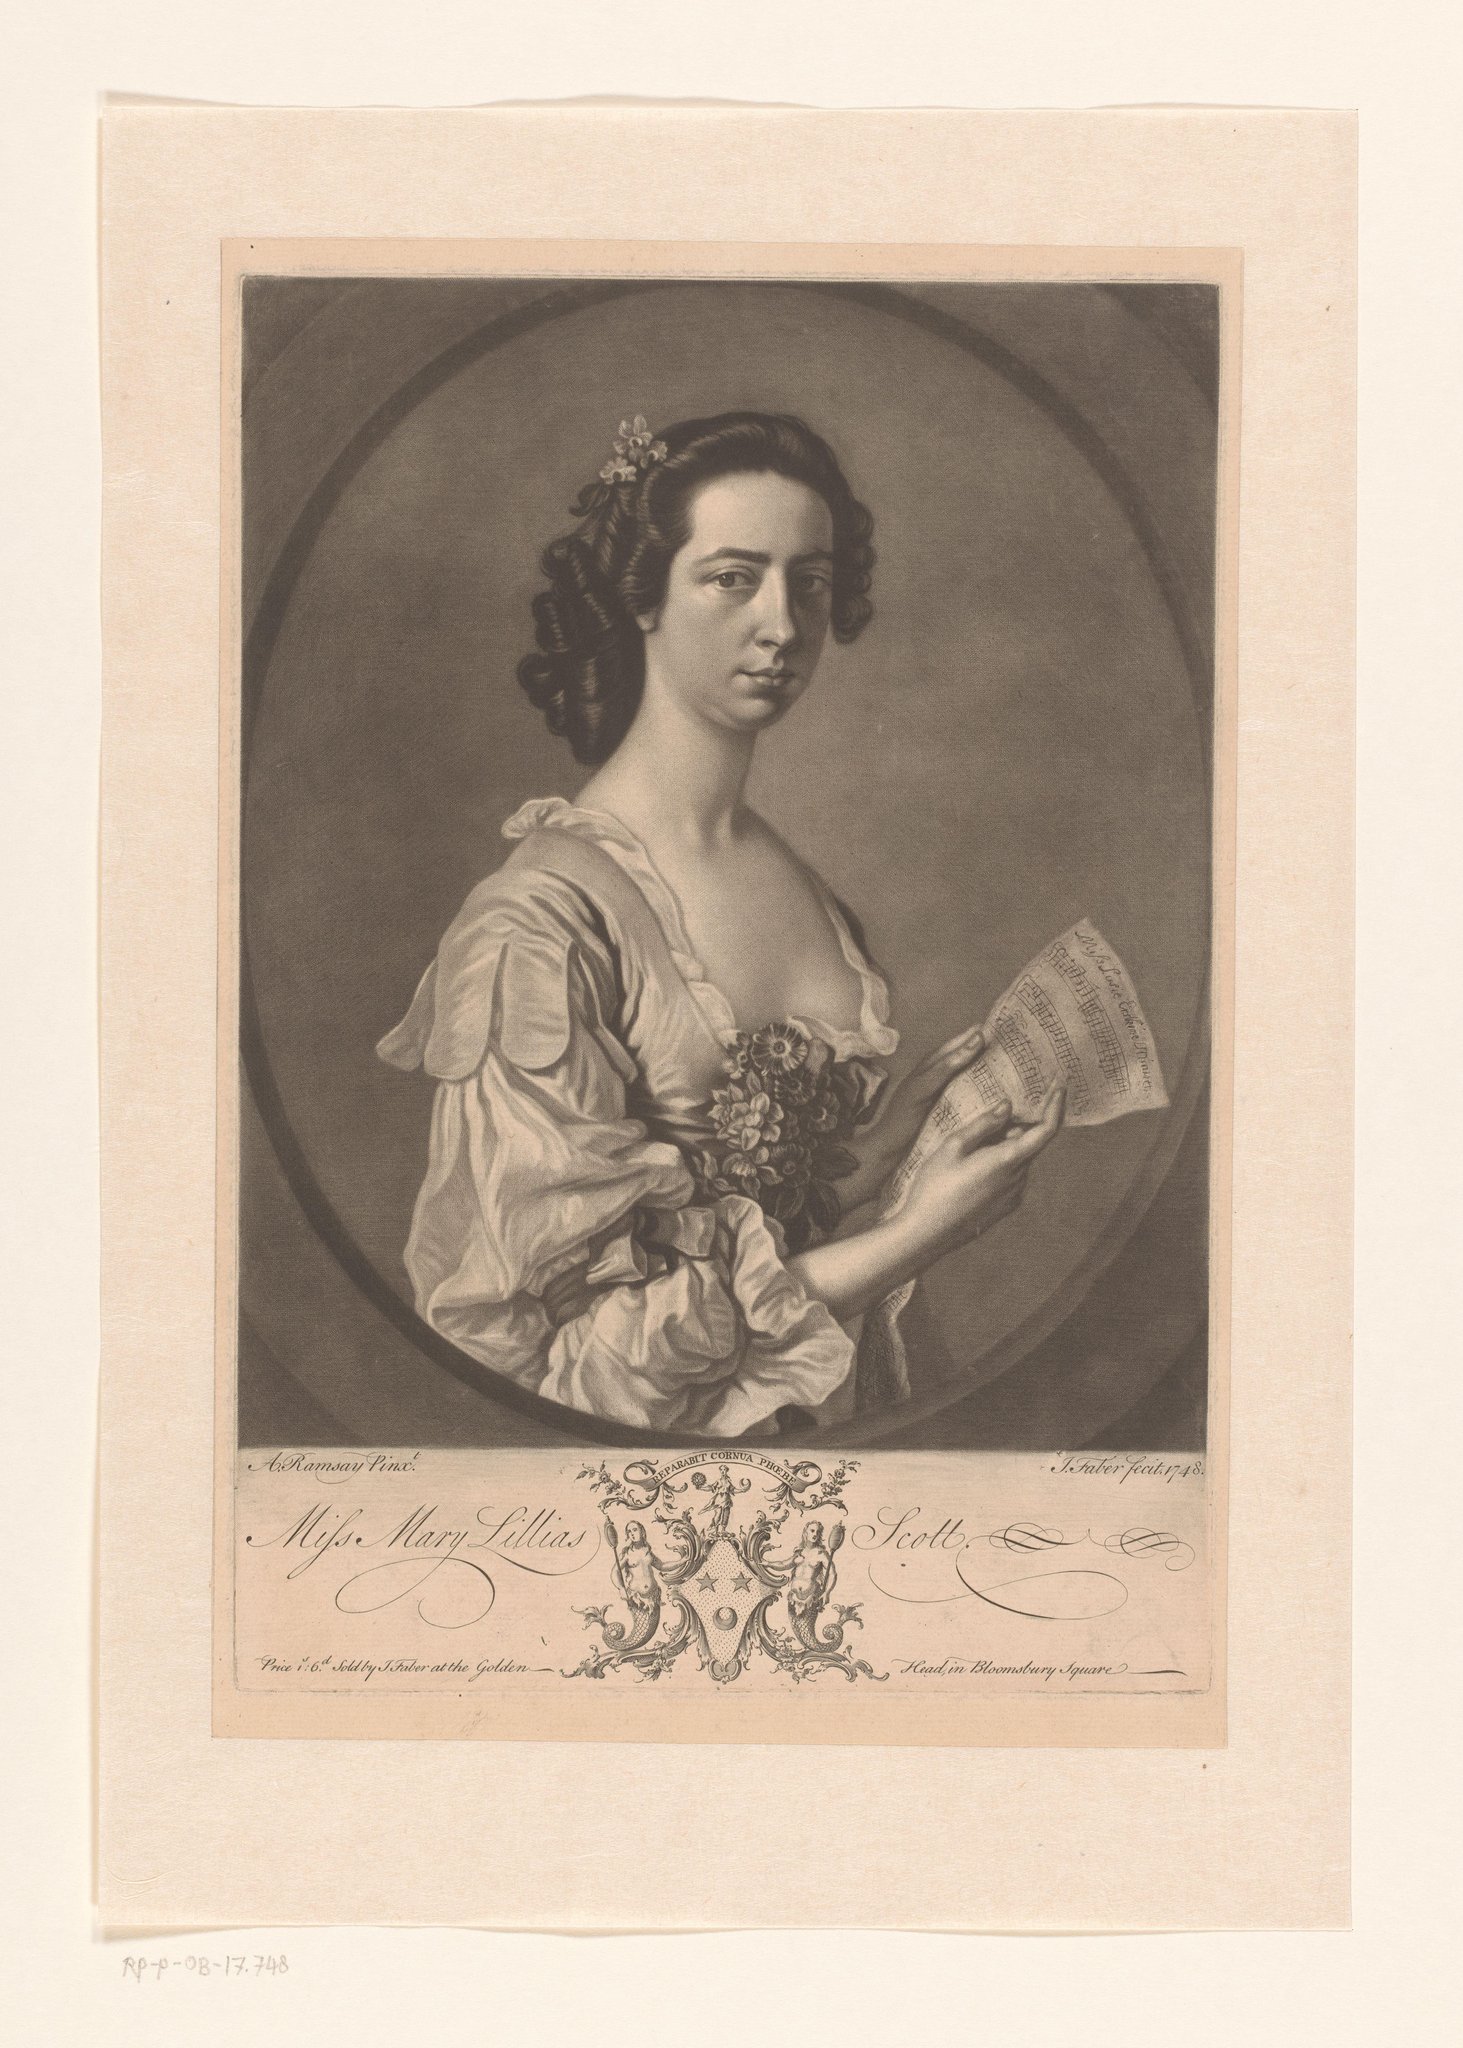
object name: print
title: Portret van Mary Lilias Scott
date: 1748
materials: paper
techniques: etching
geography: london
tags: historical persons, female singer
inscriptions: collector's mark: Lugt 240